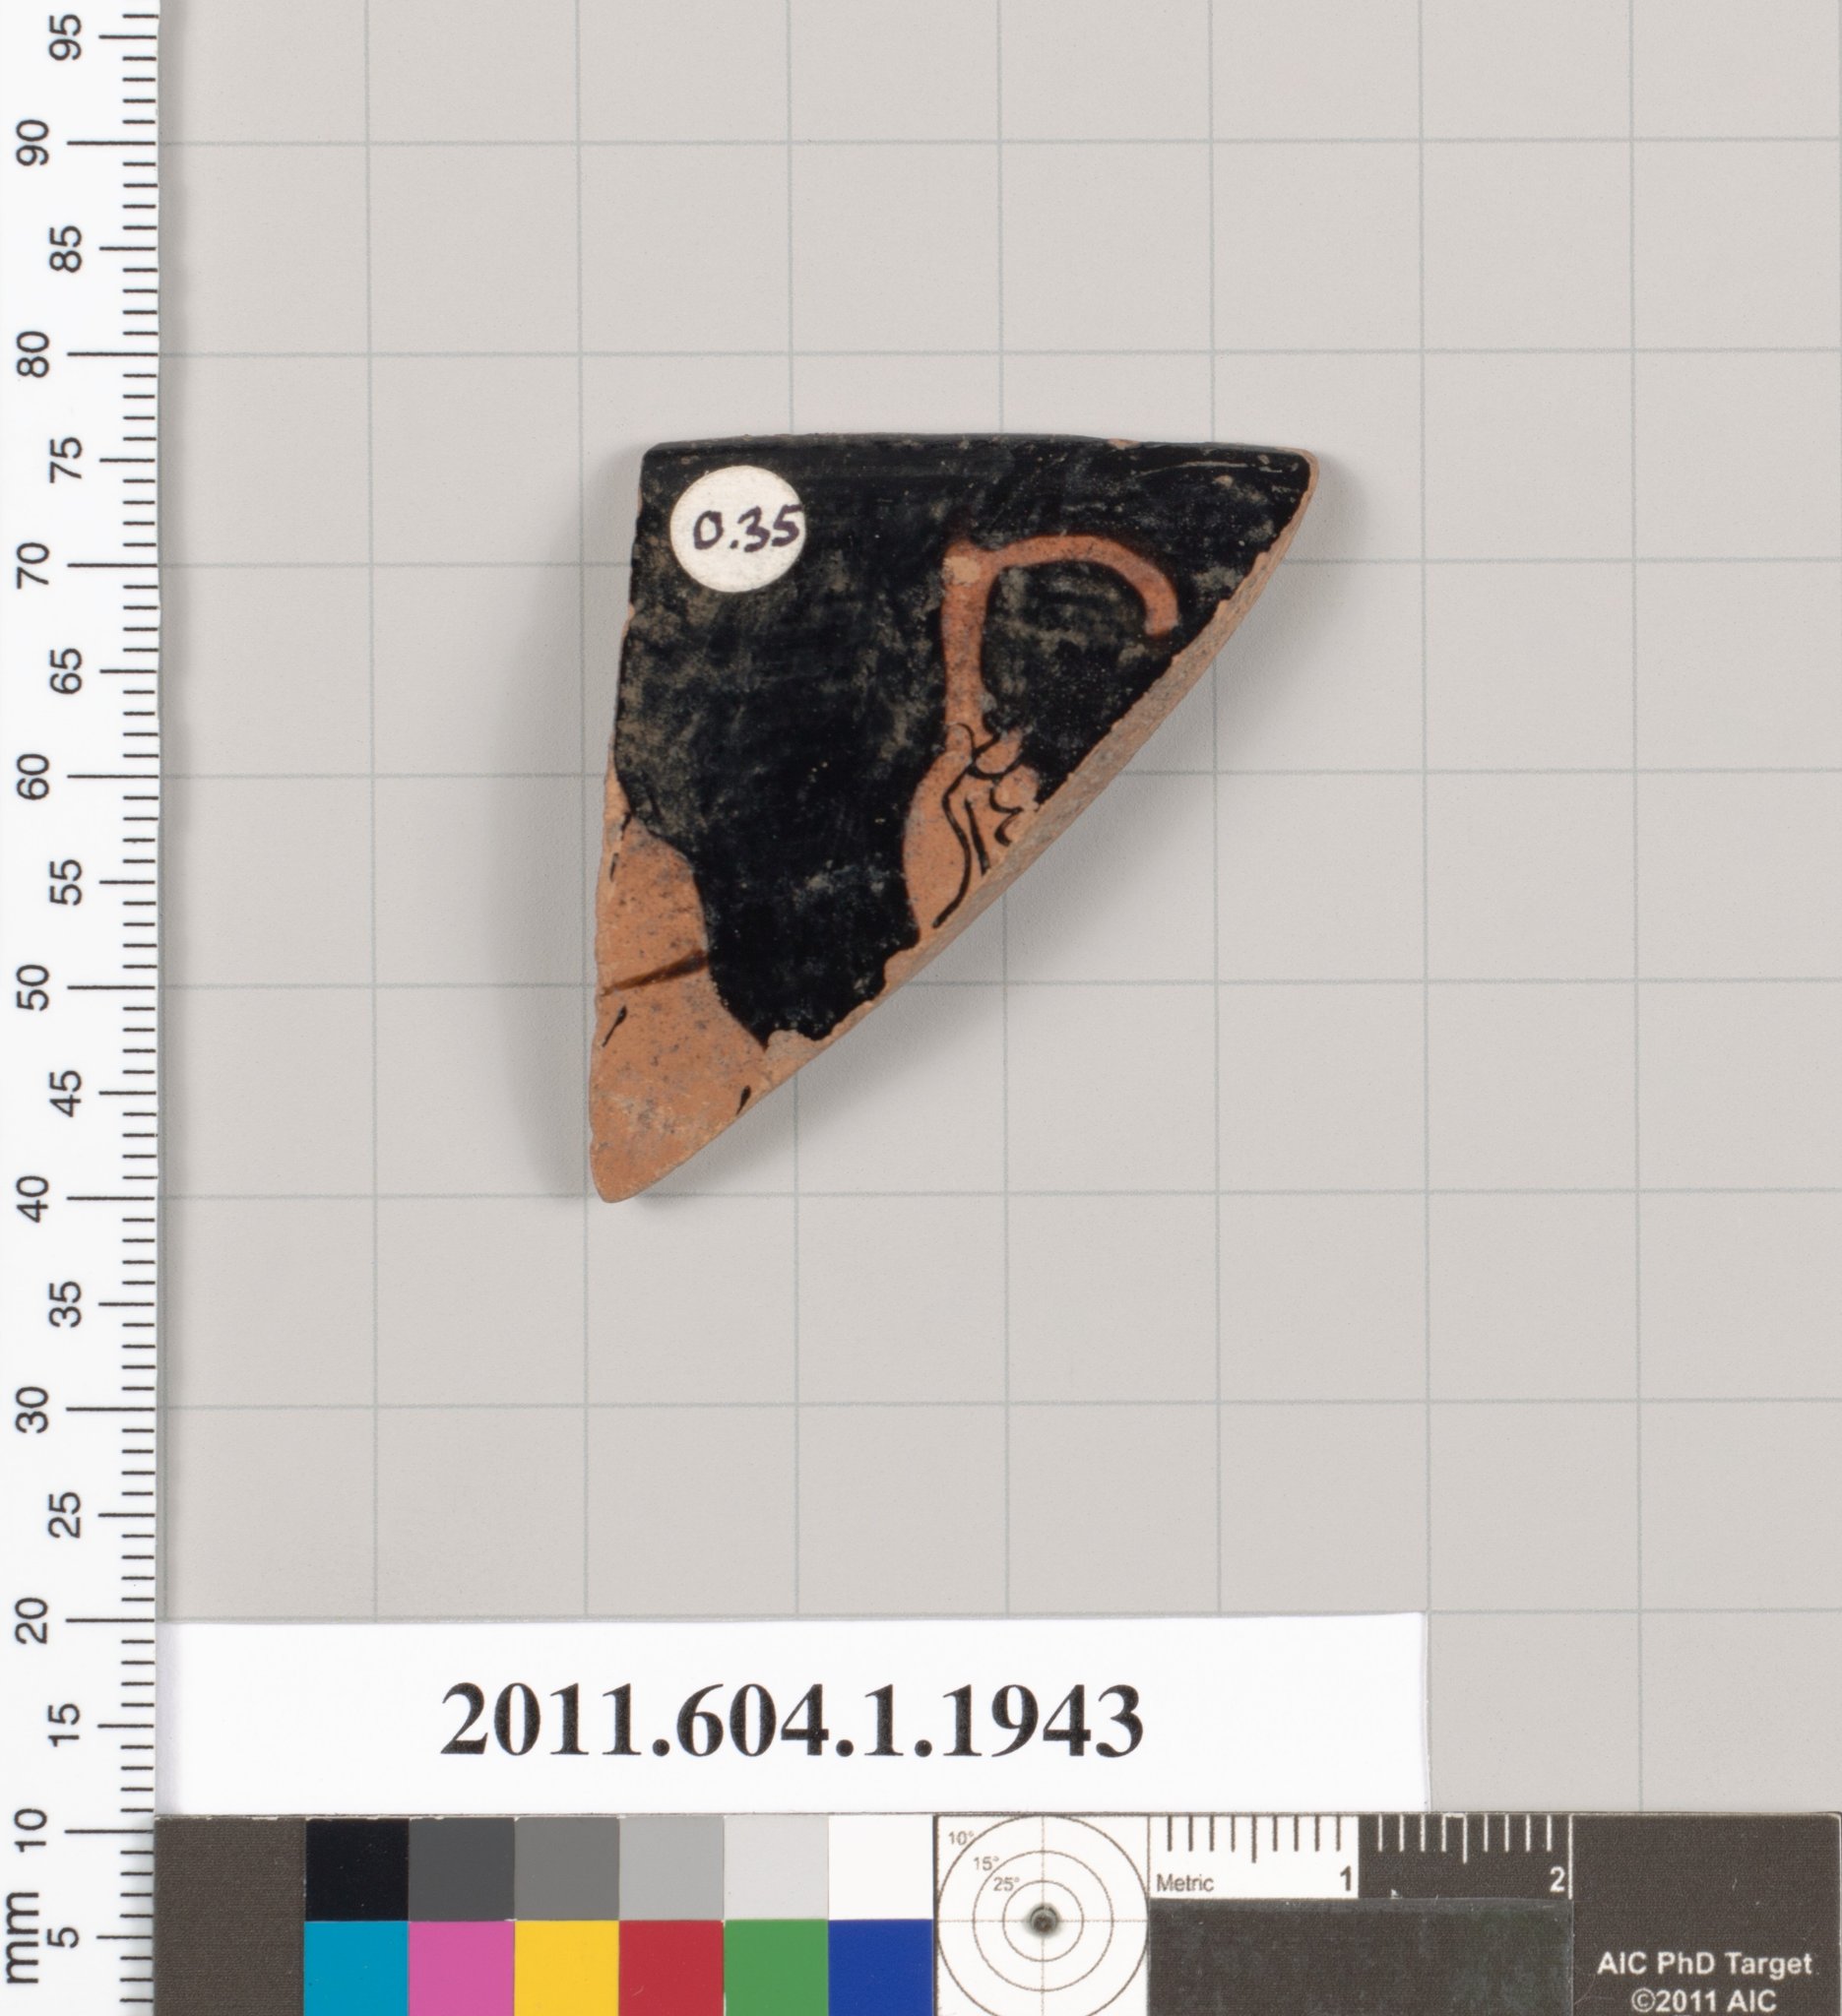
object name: kylix fragment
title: Terracotta rim fragment of a kylix (drinking cup)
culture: greek, attic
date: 475-451 BCE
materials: terracotta